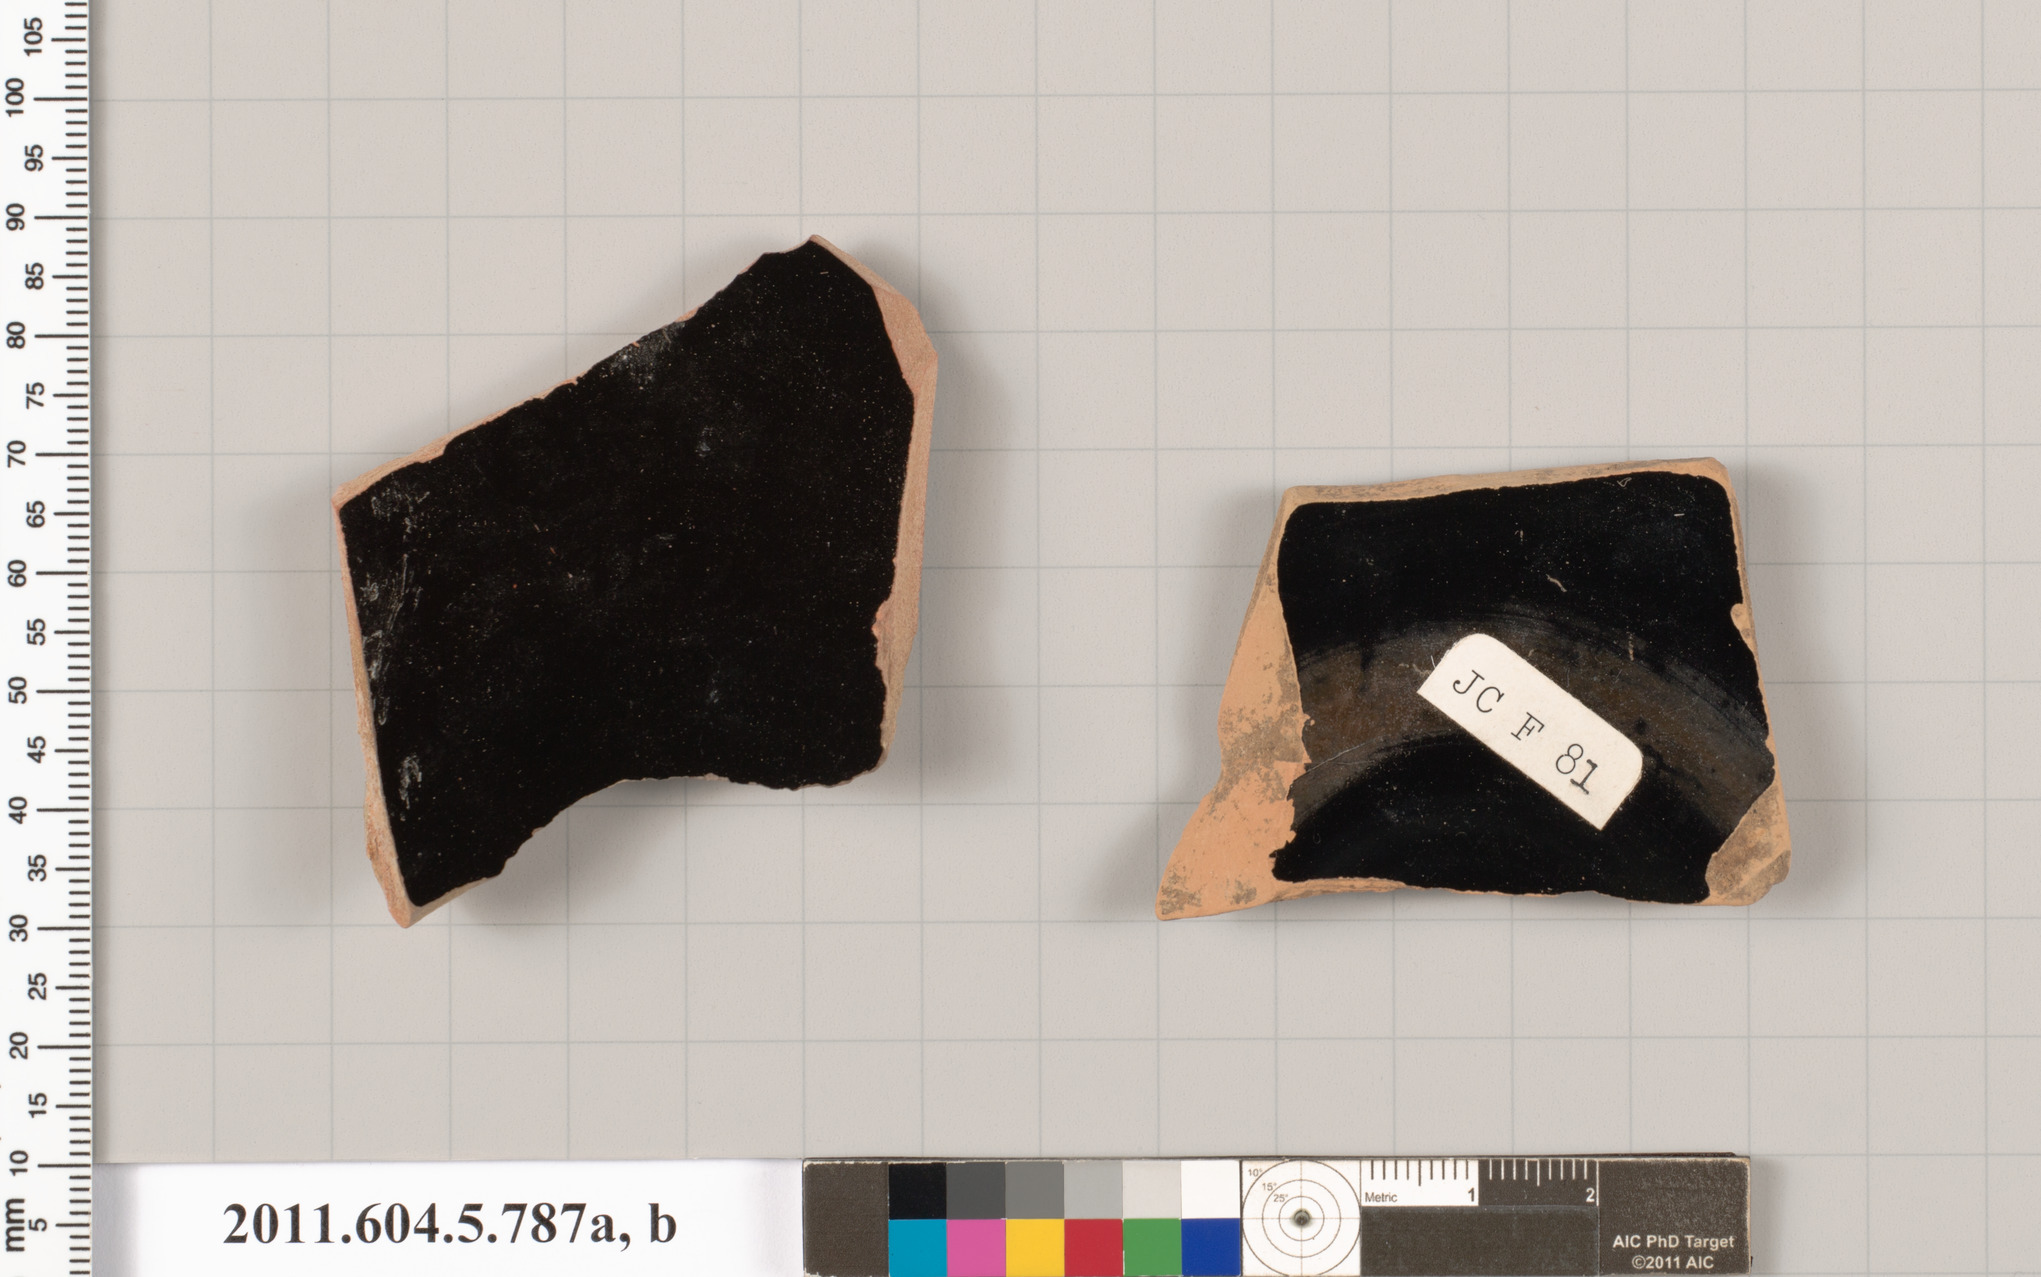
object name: kylix fragment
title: Terracotta fragments of kylikes (drinking cups)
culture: greek, attic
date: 600-401 BCE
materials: terracotta